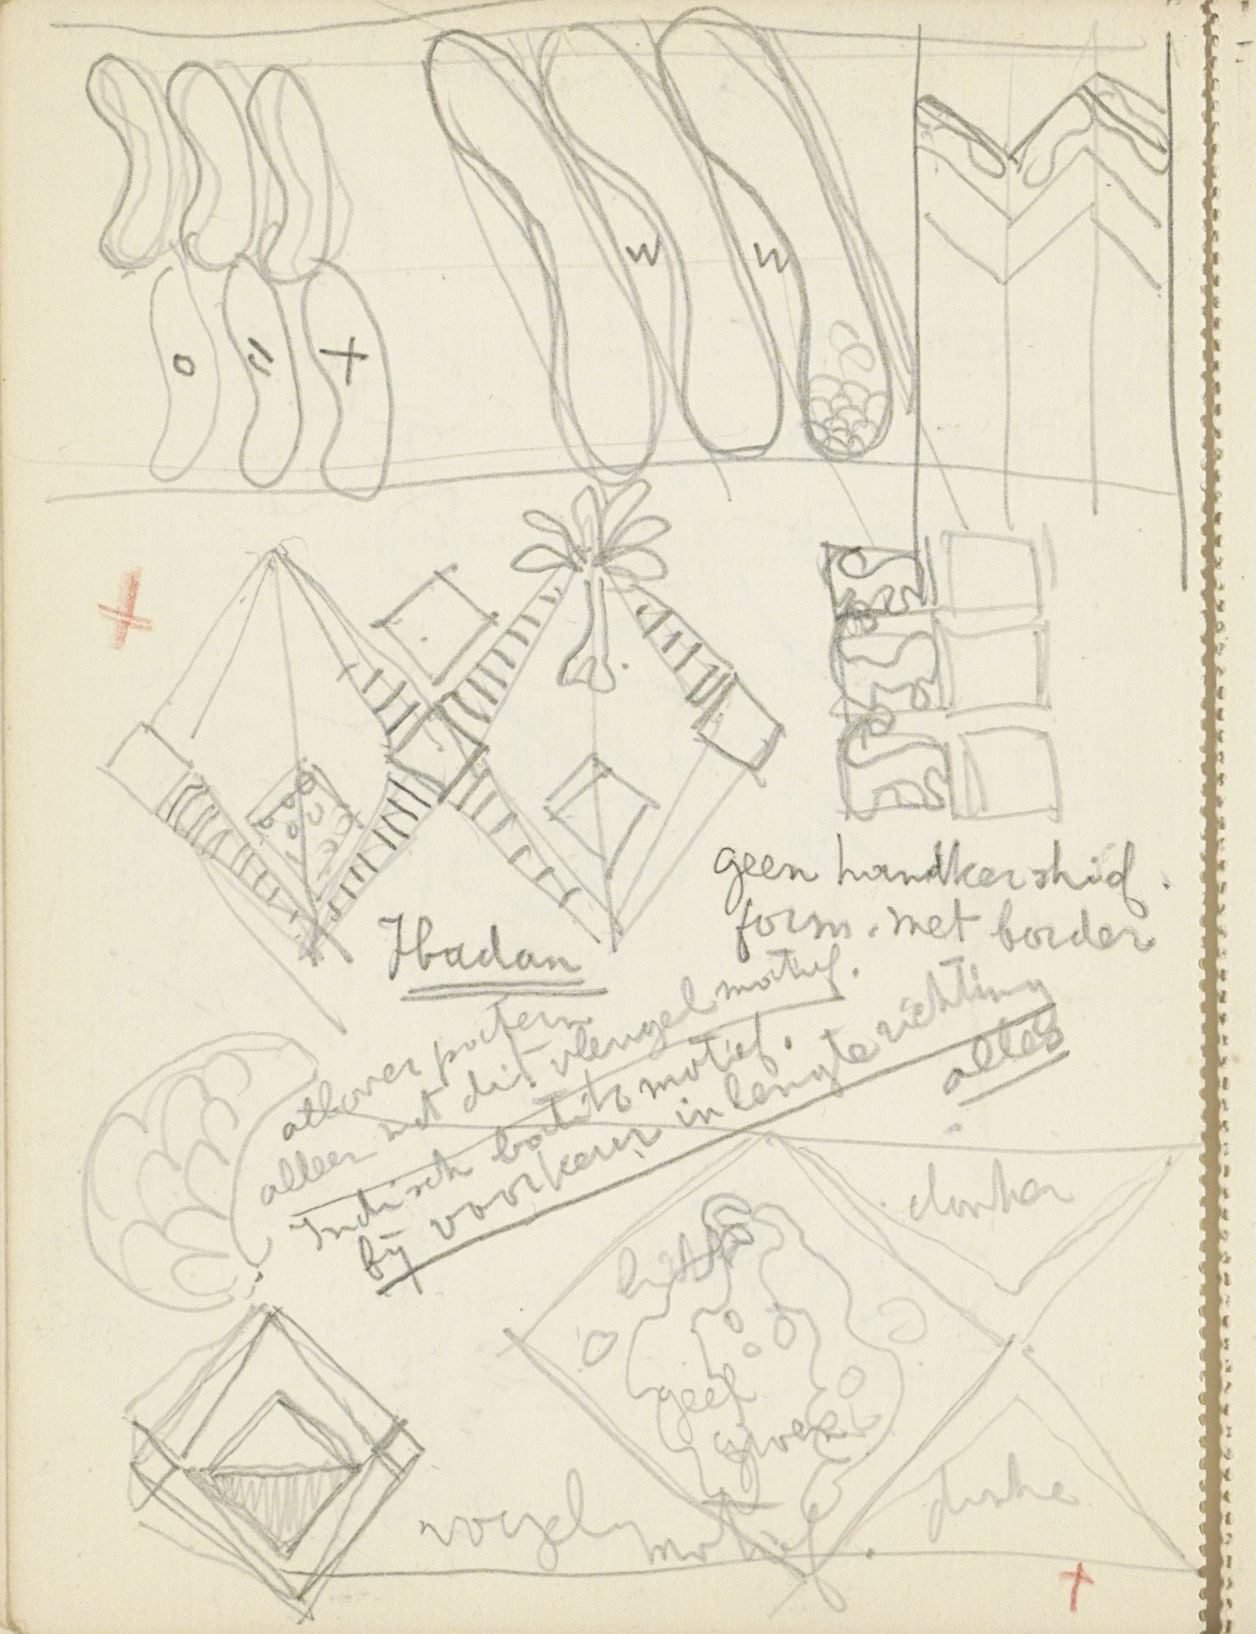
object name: sketchbook leaf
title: Batikmotieven, onder andere met vogels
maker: reijer stolk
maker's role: draughtsman, print maker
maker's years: 1896-1945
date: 1916-1945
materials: paper, pencil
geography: iran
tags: dyeing of cloth with pattern; batik-work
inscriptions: annotation: ‘Hadan/ geen handkershif/ form met border/ aaloveer po[...]/ alleen met dit vleugelmotief/ Indisch batikmotief/ bij voorkeur in lengte richting/ alles/ donker/ donker/ vogelmotief’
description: Blad 49 verso uit een schetsboek met 60 bladen.